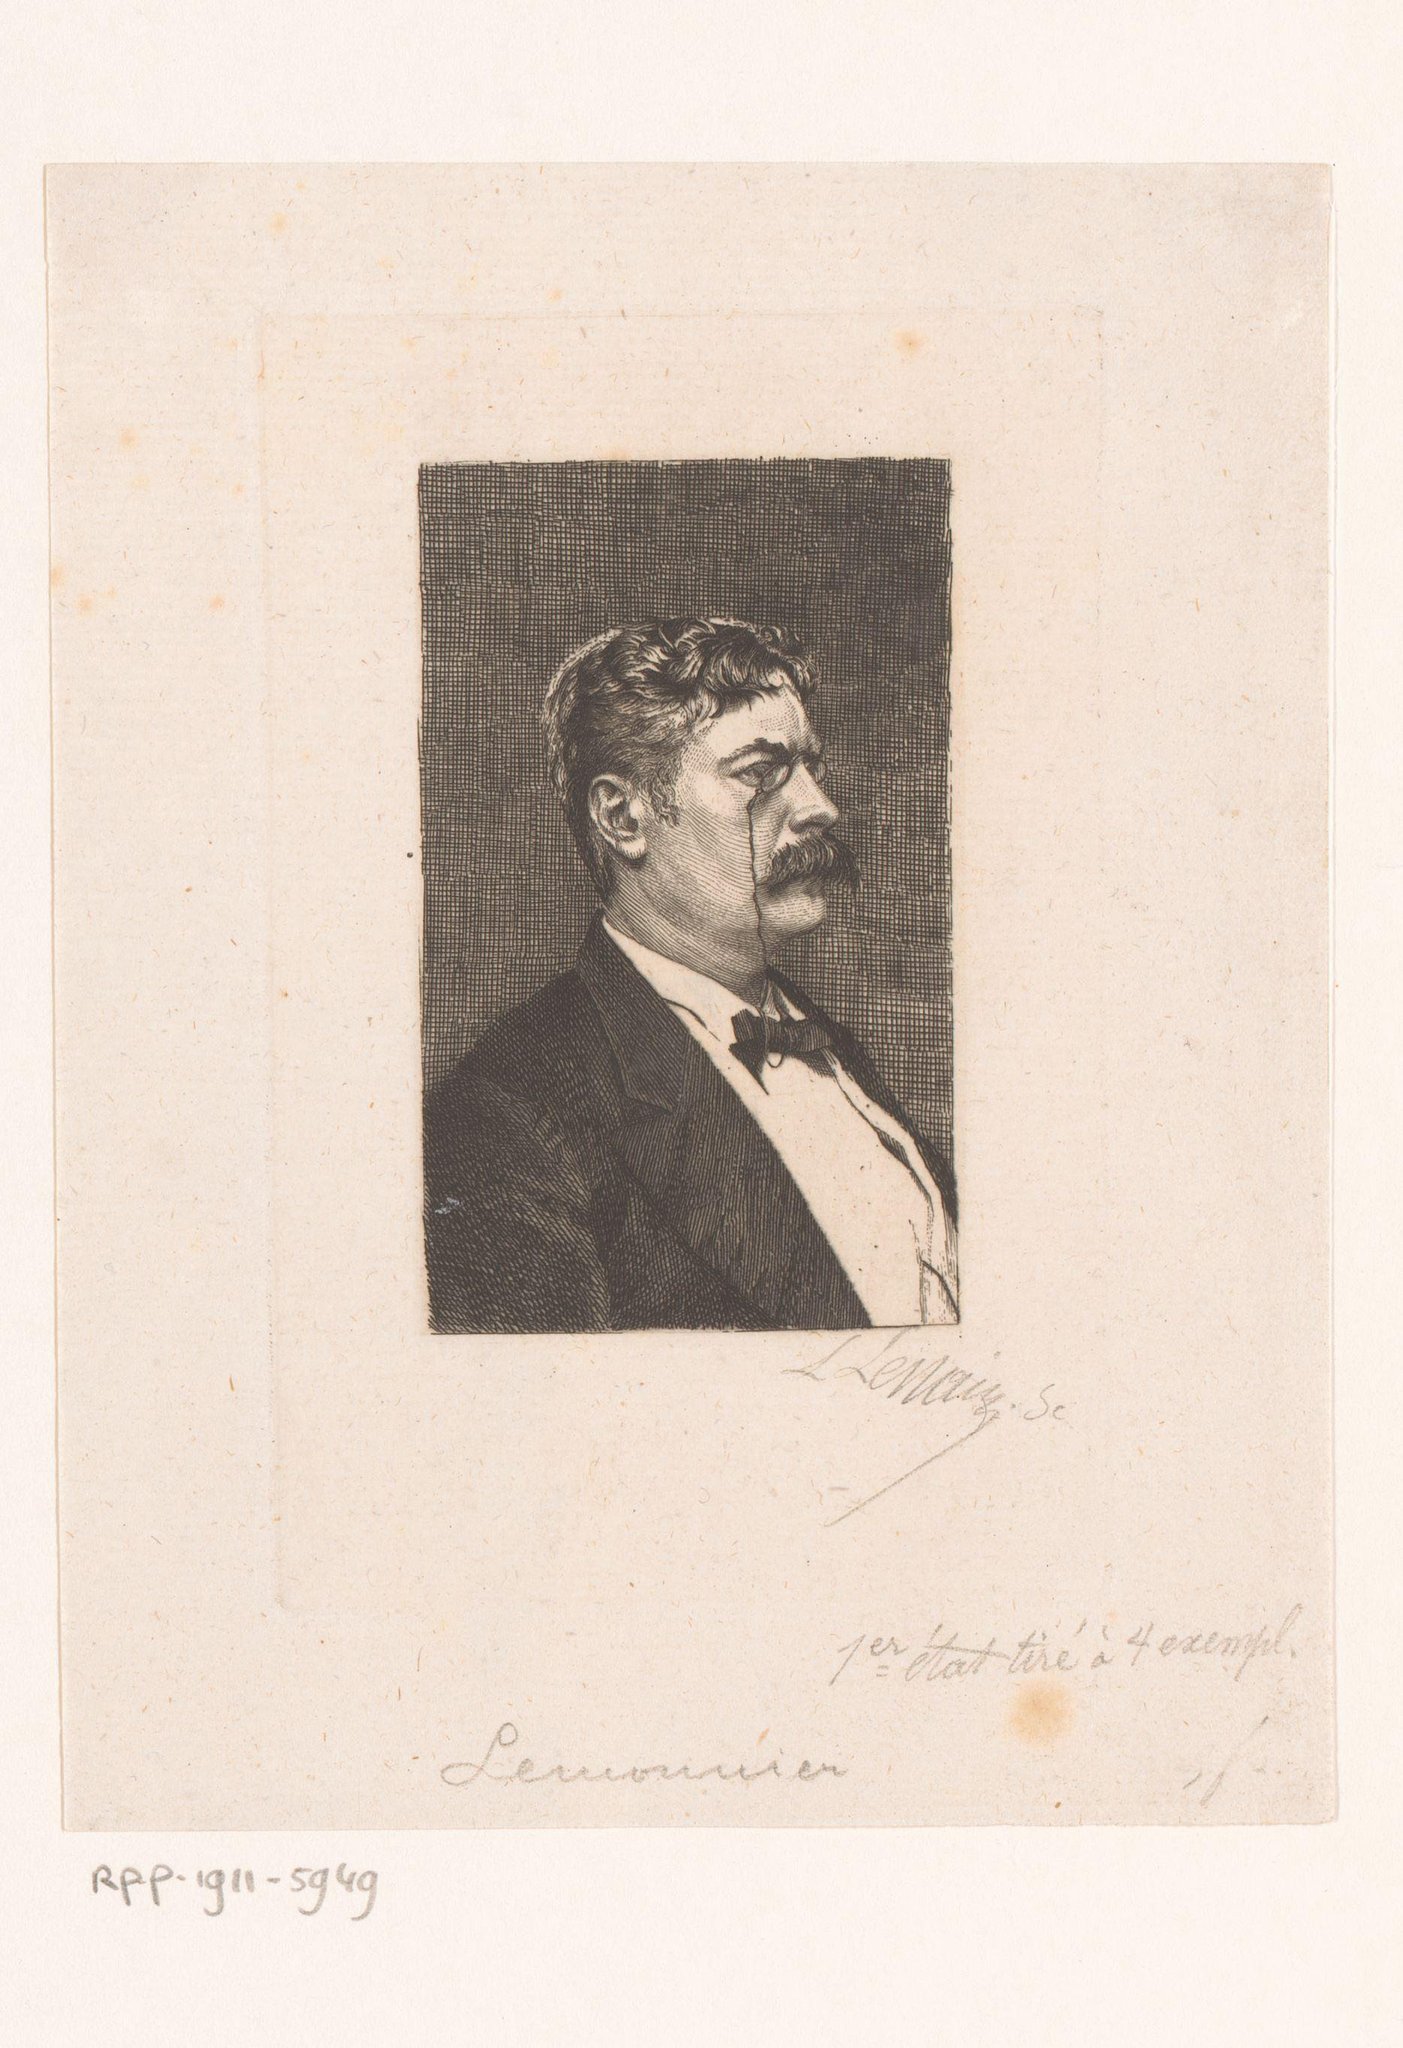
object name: print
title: Portret van Camille Lemonnier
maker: louis le nain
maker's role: print maker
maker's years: 1851-1939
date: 1861-1911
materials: paper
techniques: etching, intaglio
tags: camille lemonnier, eyeglasses, spectacles, adult man, historical persons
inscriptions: inscription: ‘1er état tiré à 4 exempl.’, collector's mark: Lugt 2228